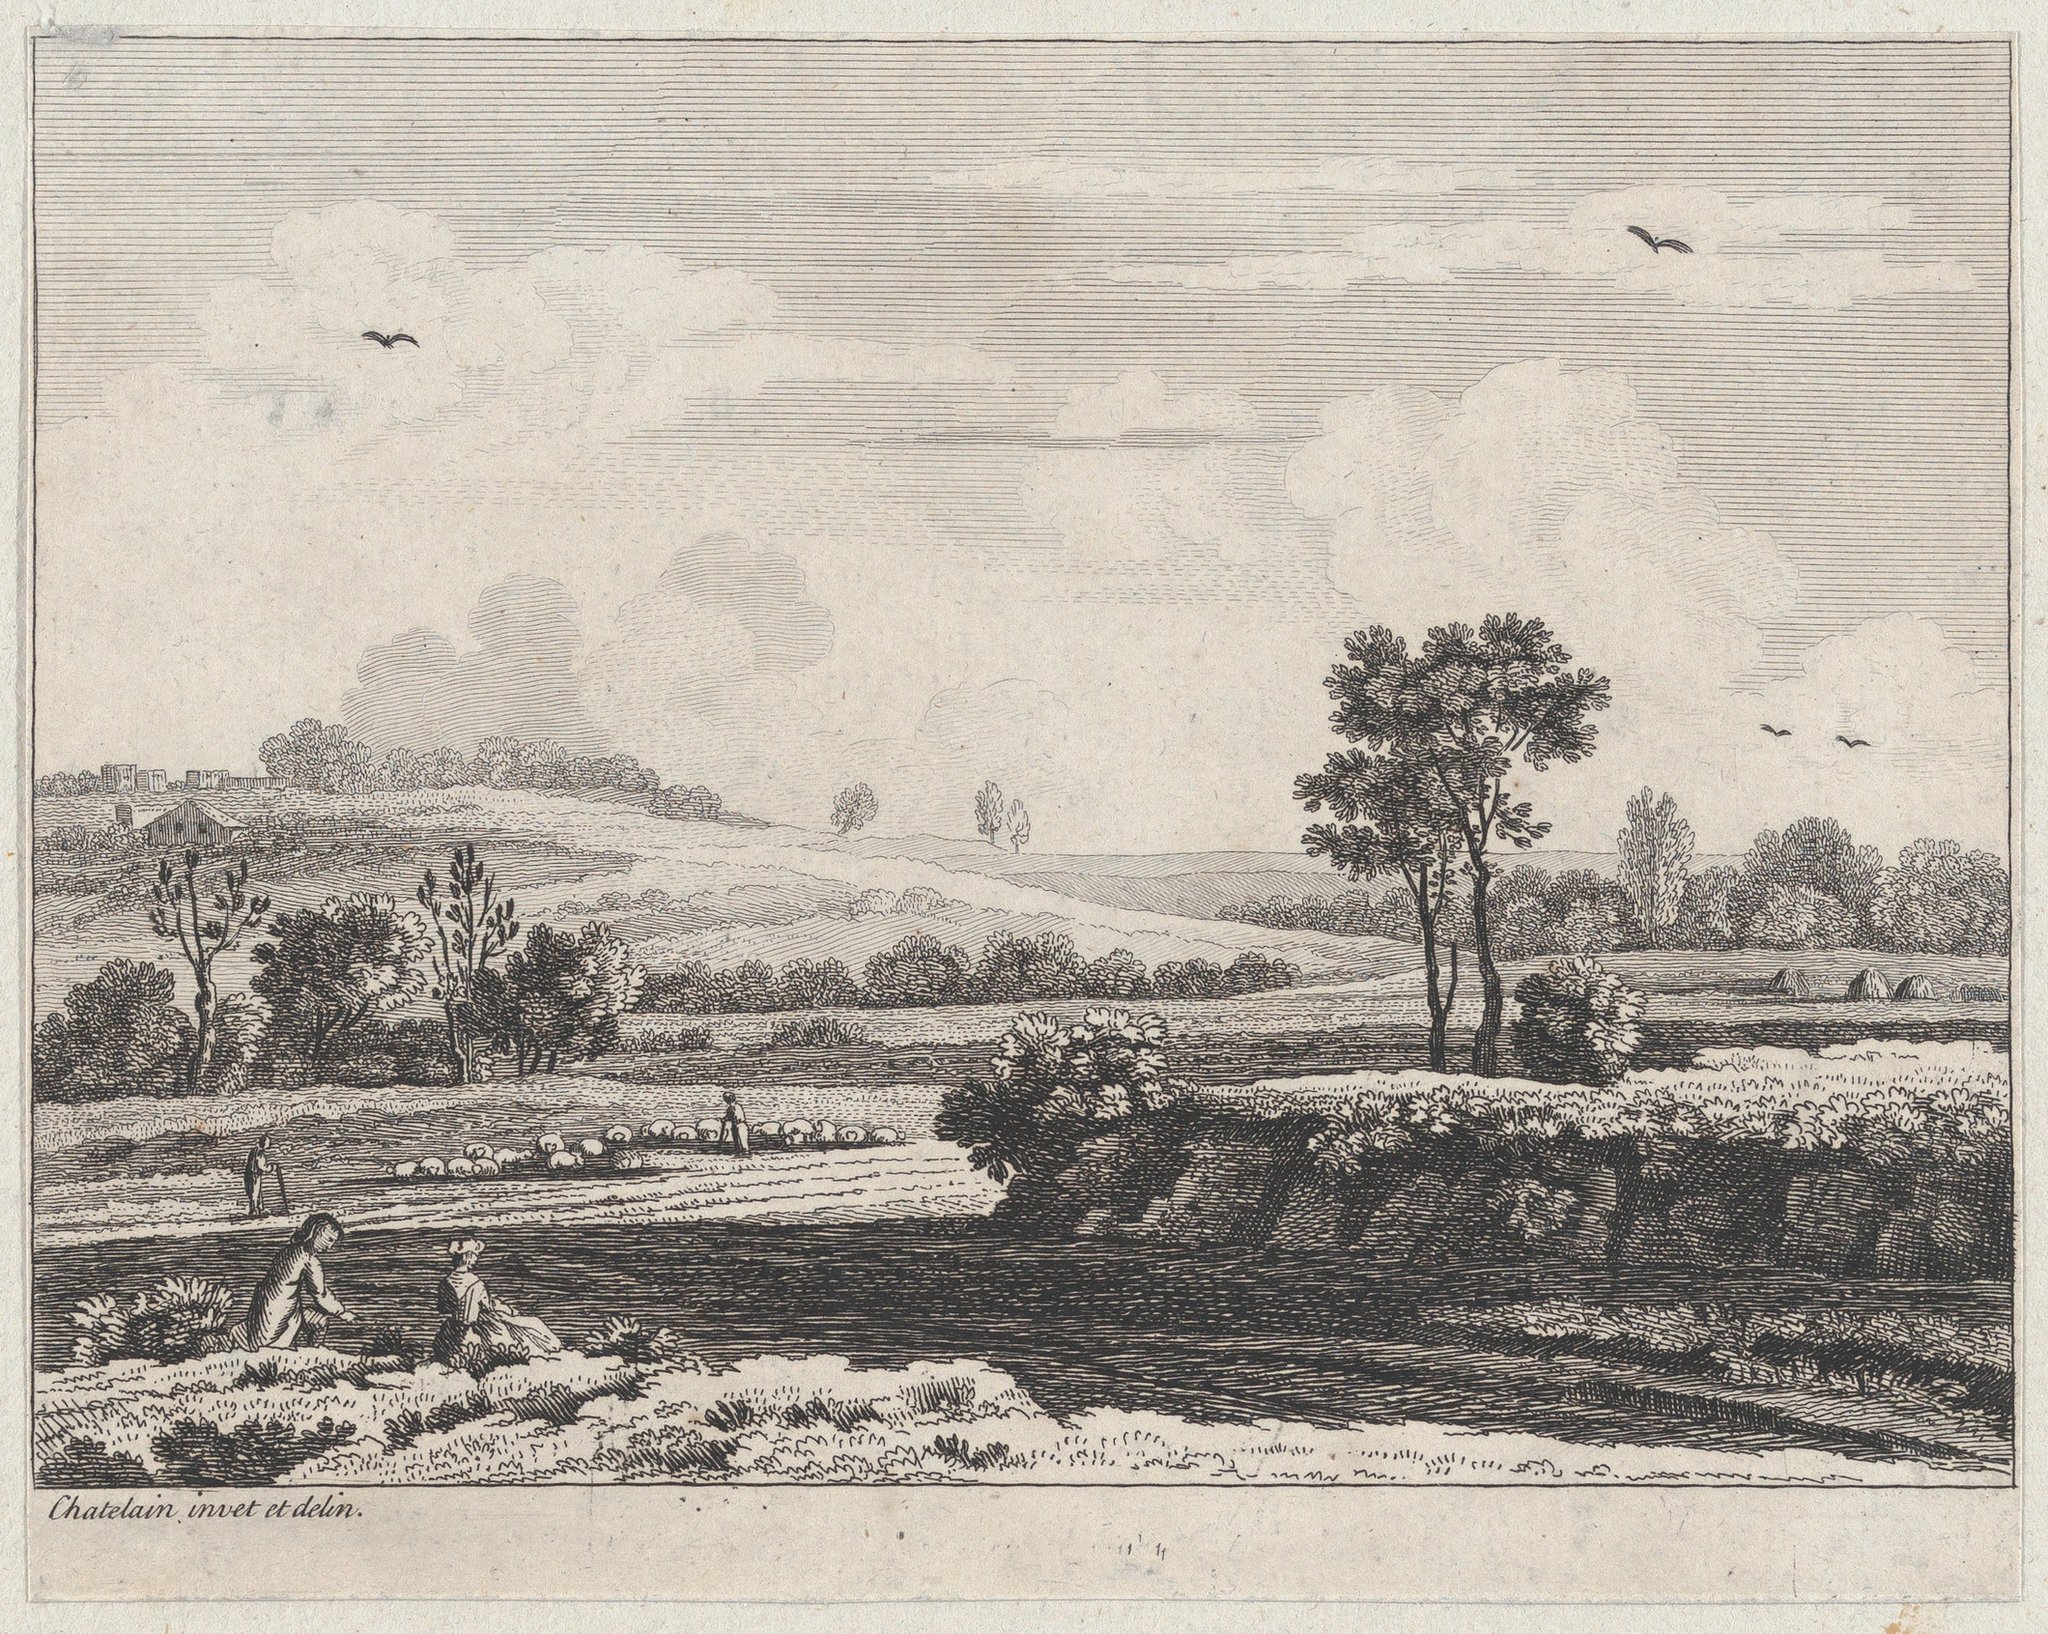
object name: print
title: Landscape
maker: jean-baptiste-claude chatelain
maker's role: artist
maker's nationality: british, french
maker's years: 1705-1758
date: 1730-1758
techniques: etching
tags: landscapes,trees